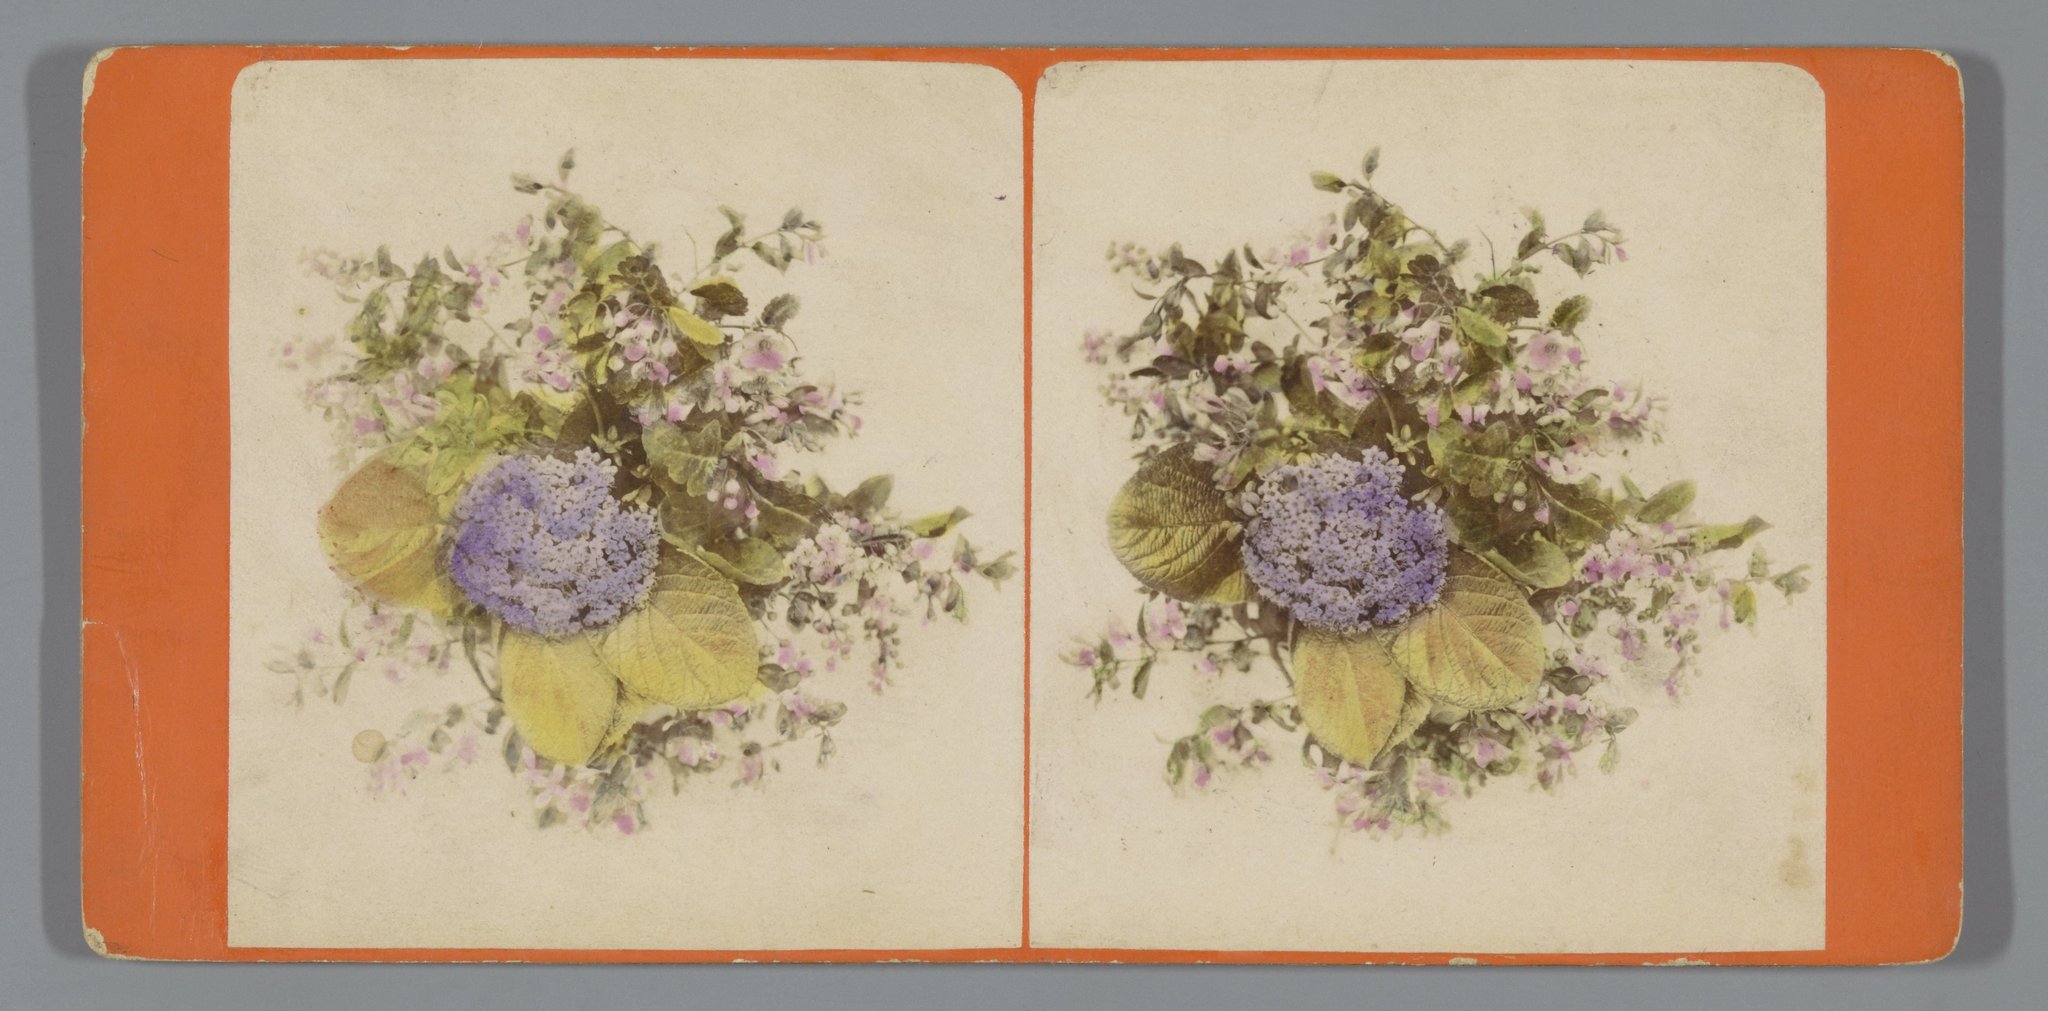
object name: stereograph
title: Bloemstilleven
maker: Anonymous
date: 1855-1870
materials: cardboard, photographic support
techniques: albumen print, hand coloring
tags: cut flowers; nosegay, bunch of flowers